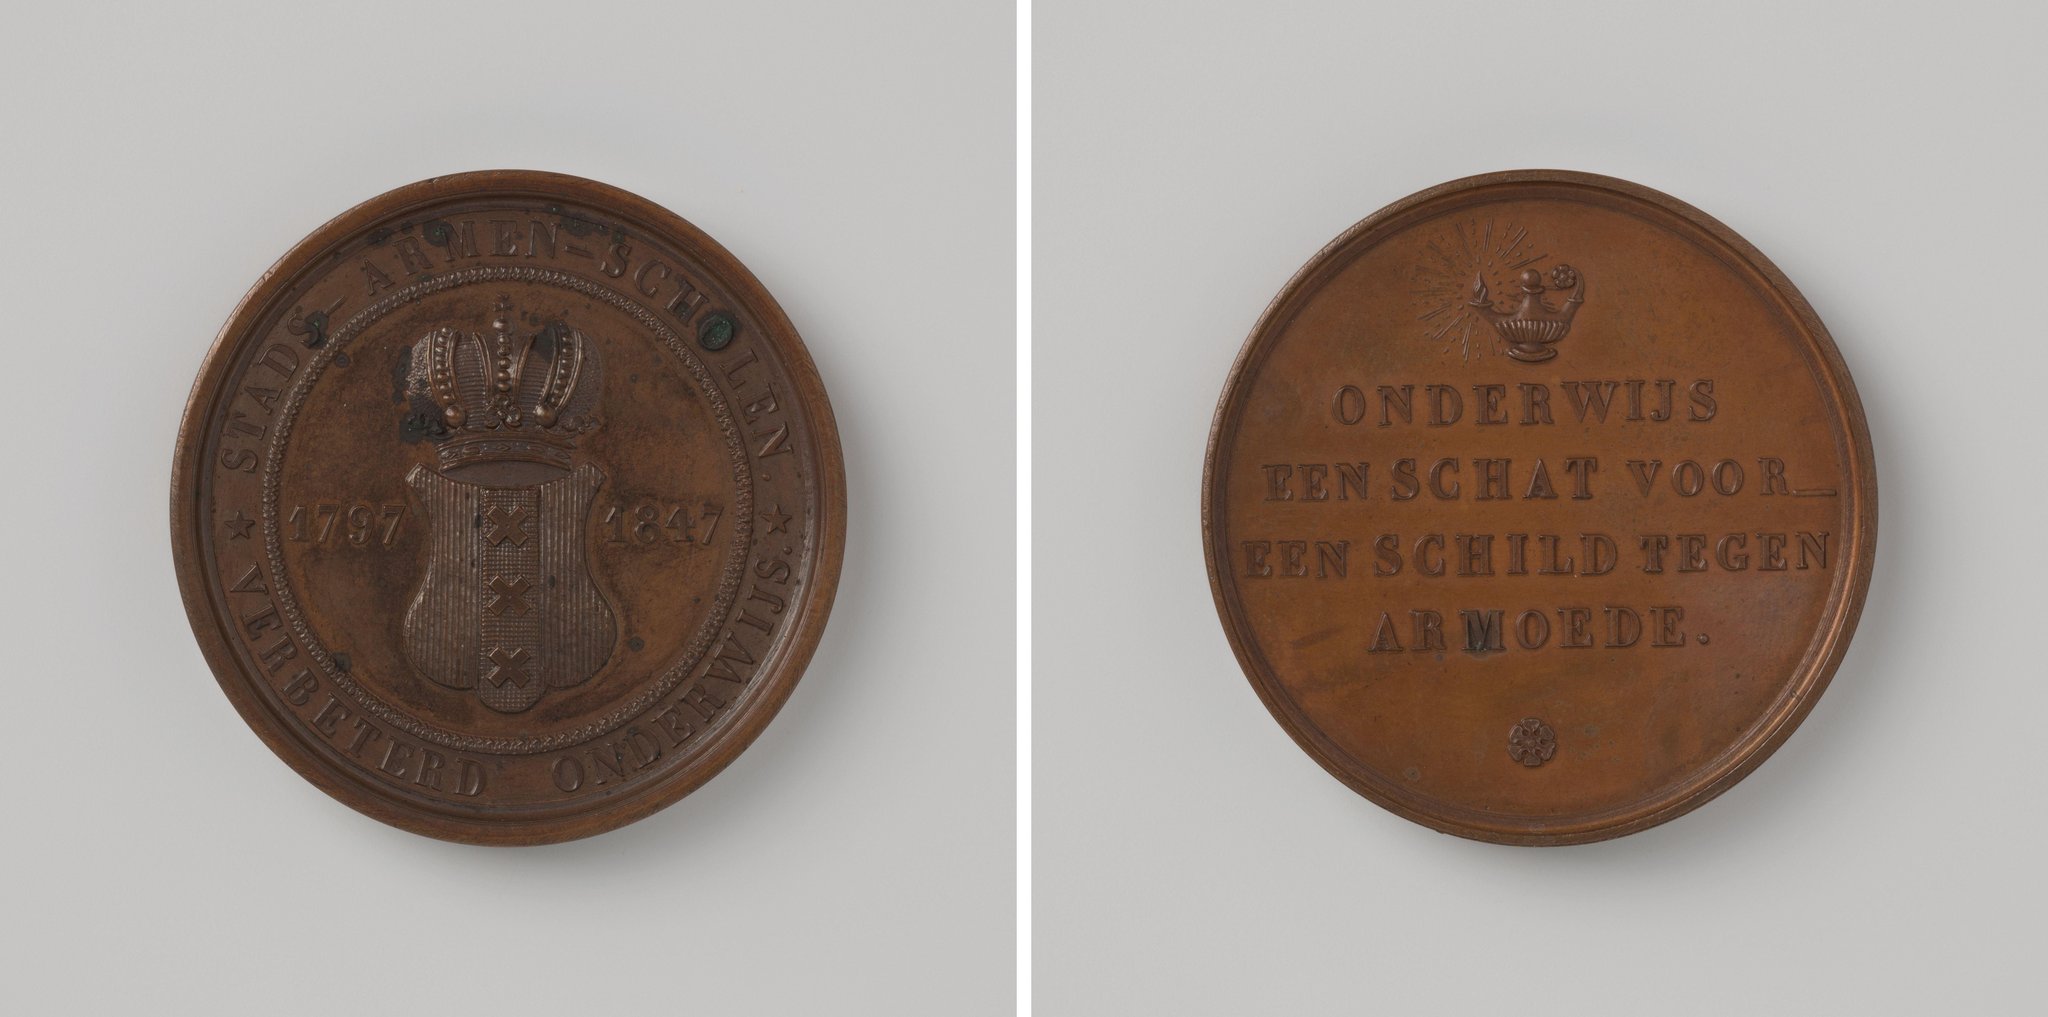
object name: history medal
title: Vijftigjarig bestaan van de Stads-Armen-Scholen te Amsterdam 1847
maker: johannis petrus schouberg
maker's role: die cutter, draughtsman, print maker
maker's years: 1798-1864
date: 1847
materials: bronze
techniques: striking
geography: utrecht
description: Bronzen penning, op de voorzijde het gekroonde Amsterdamse stadswapen tussen 1797 en 1847, met omschrift, op de keerzijde vier regels tekst en een rozet onder een brandend olielampje.